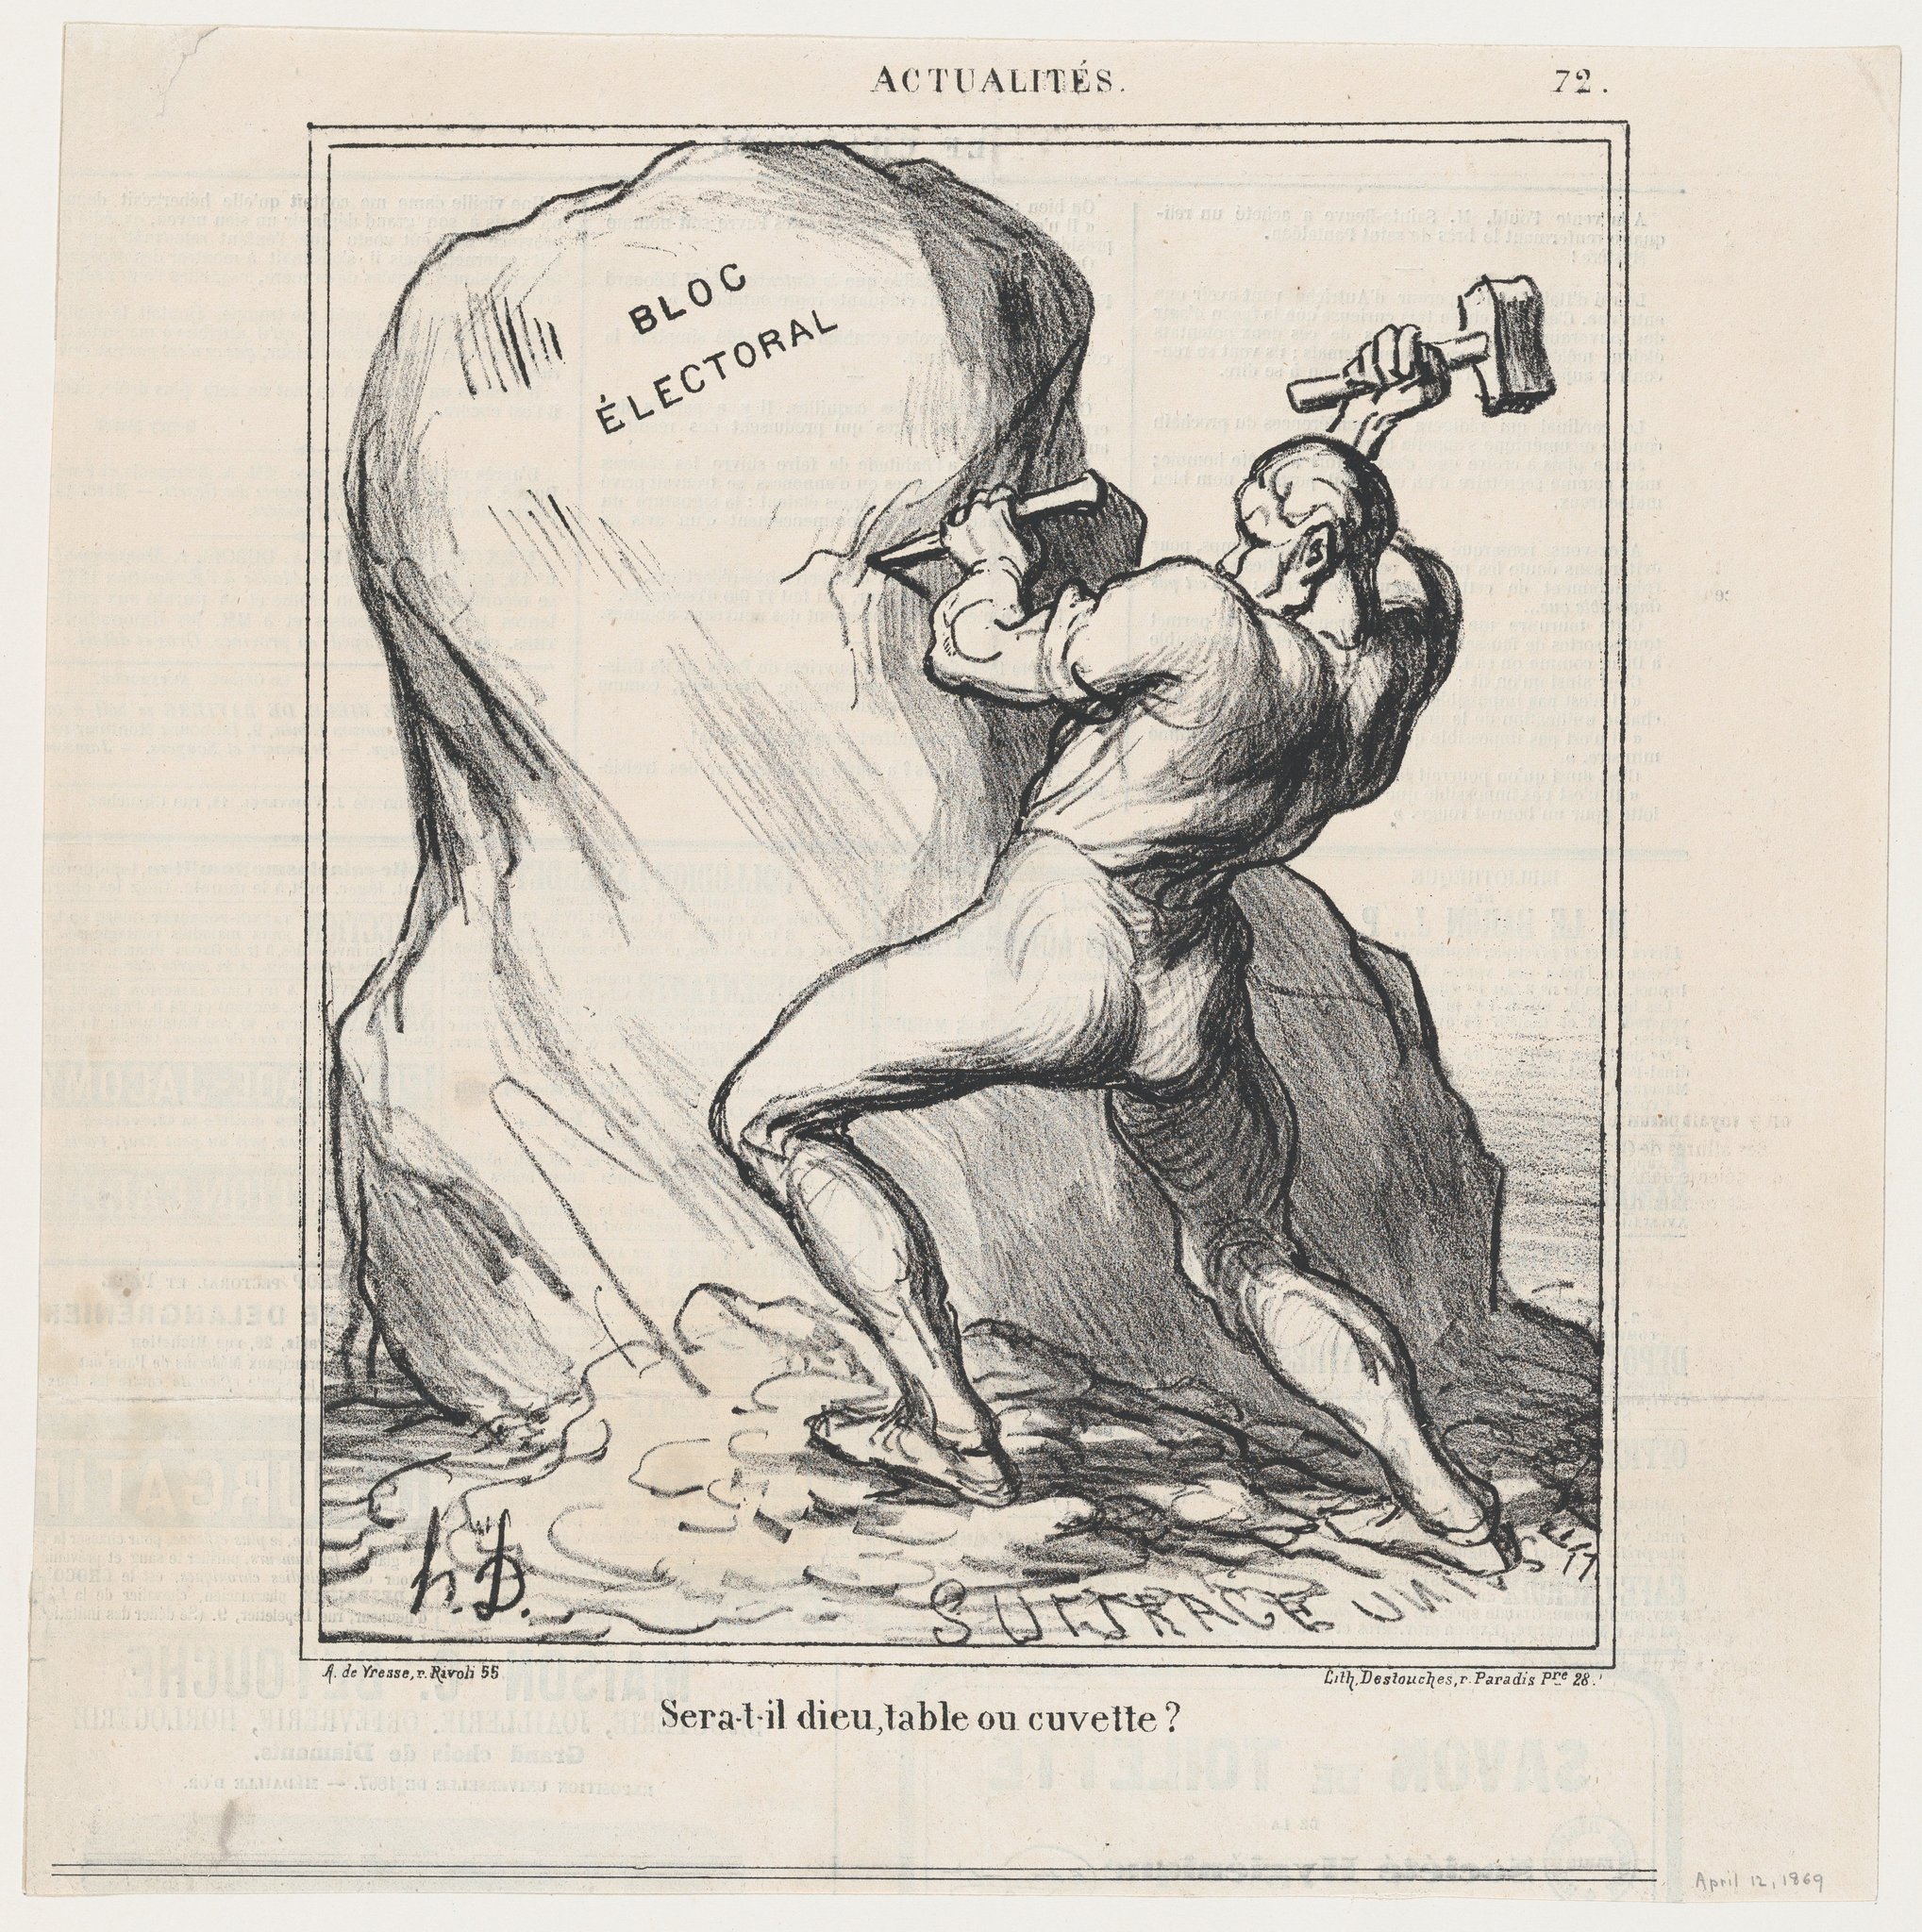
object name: print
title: Will he be God, a table, or a basin?, from 'News of the day,' published in Le Charivari, April 12, 1869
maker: honoré daumier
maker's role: artist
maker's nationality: french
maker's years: 1808-1879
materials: paper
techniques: lithograph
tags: men,working